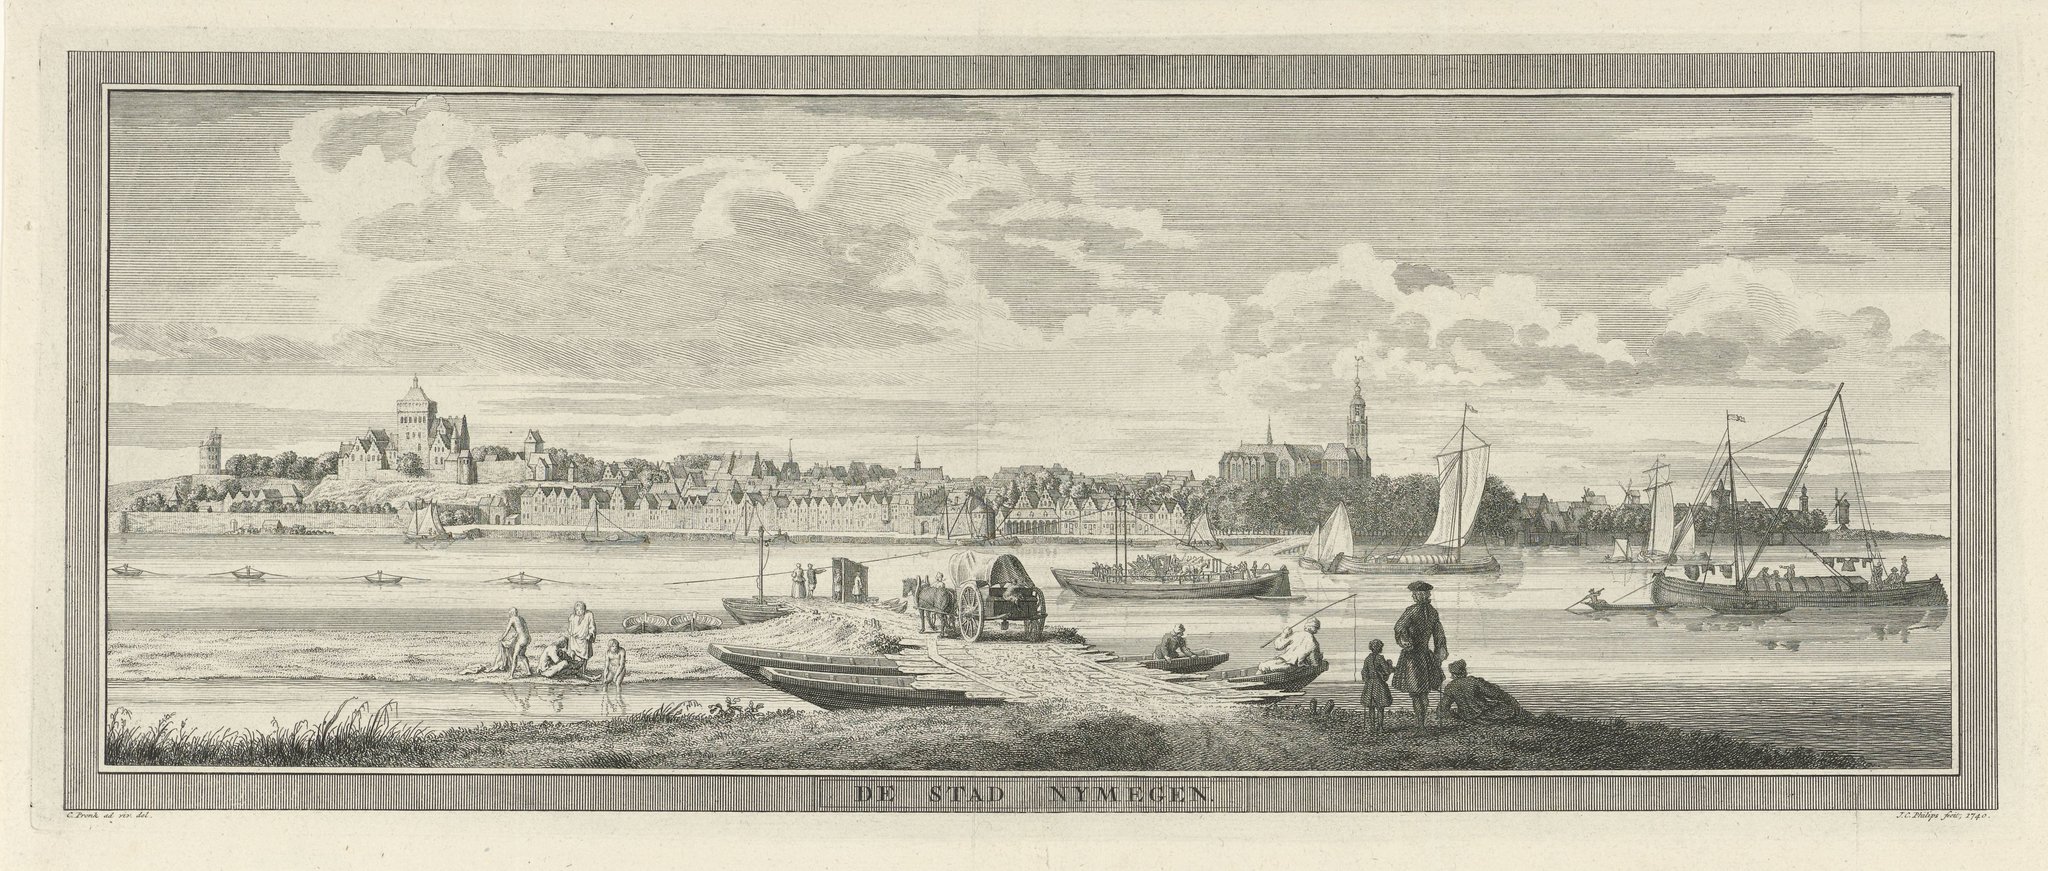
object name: print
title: De stad Nymegen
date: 1740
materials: paper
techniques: etching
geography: amsterdam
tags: city-view in general; 'veduta', nijmegen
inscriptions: collector's mark: Lugt 2228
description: Prent ook gebruikt in: Wagenaar, Jan. Tegenwoordige staat der Vereenigde Nederlanden, derde deel. Vervattende de beschryving der provincie Gelderland (…) / Hedendaagsche historie, of tegenwoordige staat van alle volkeren; XIIIde deel (…). Amsterdam: Isaak Tirion, 1741.